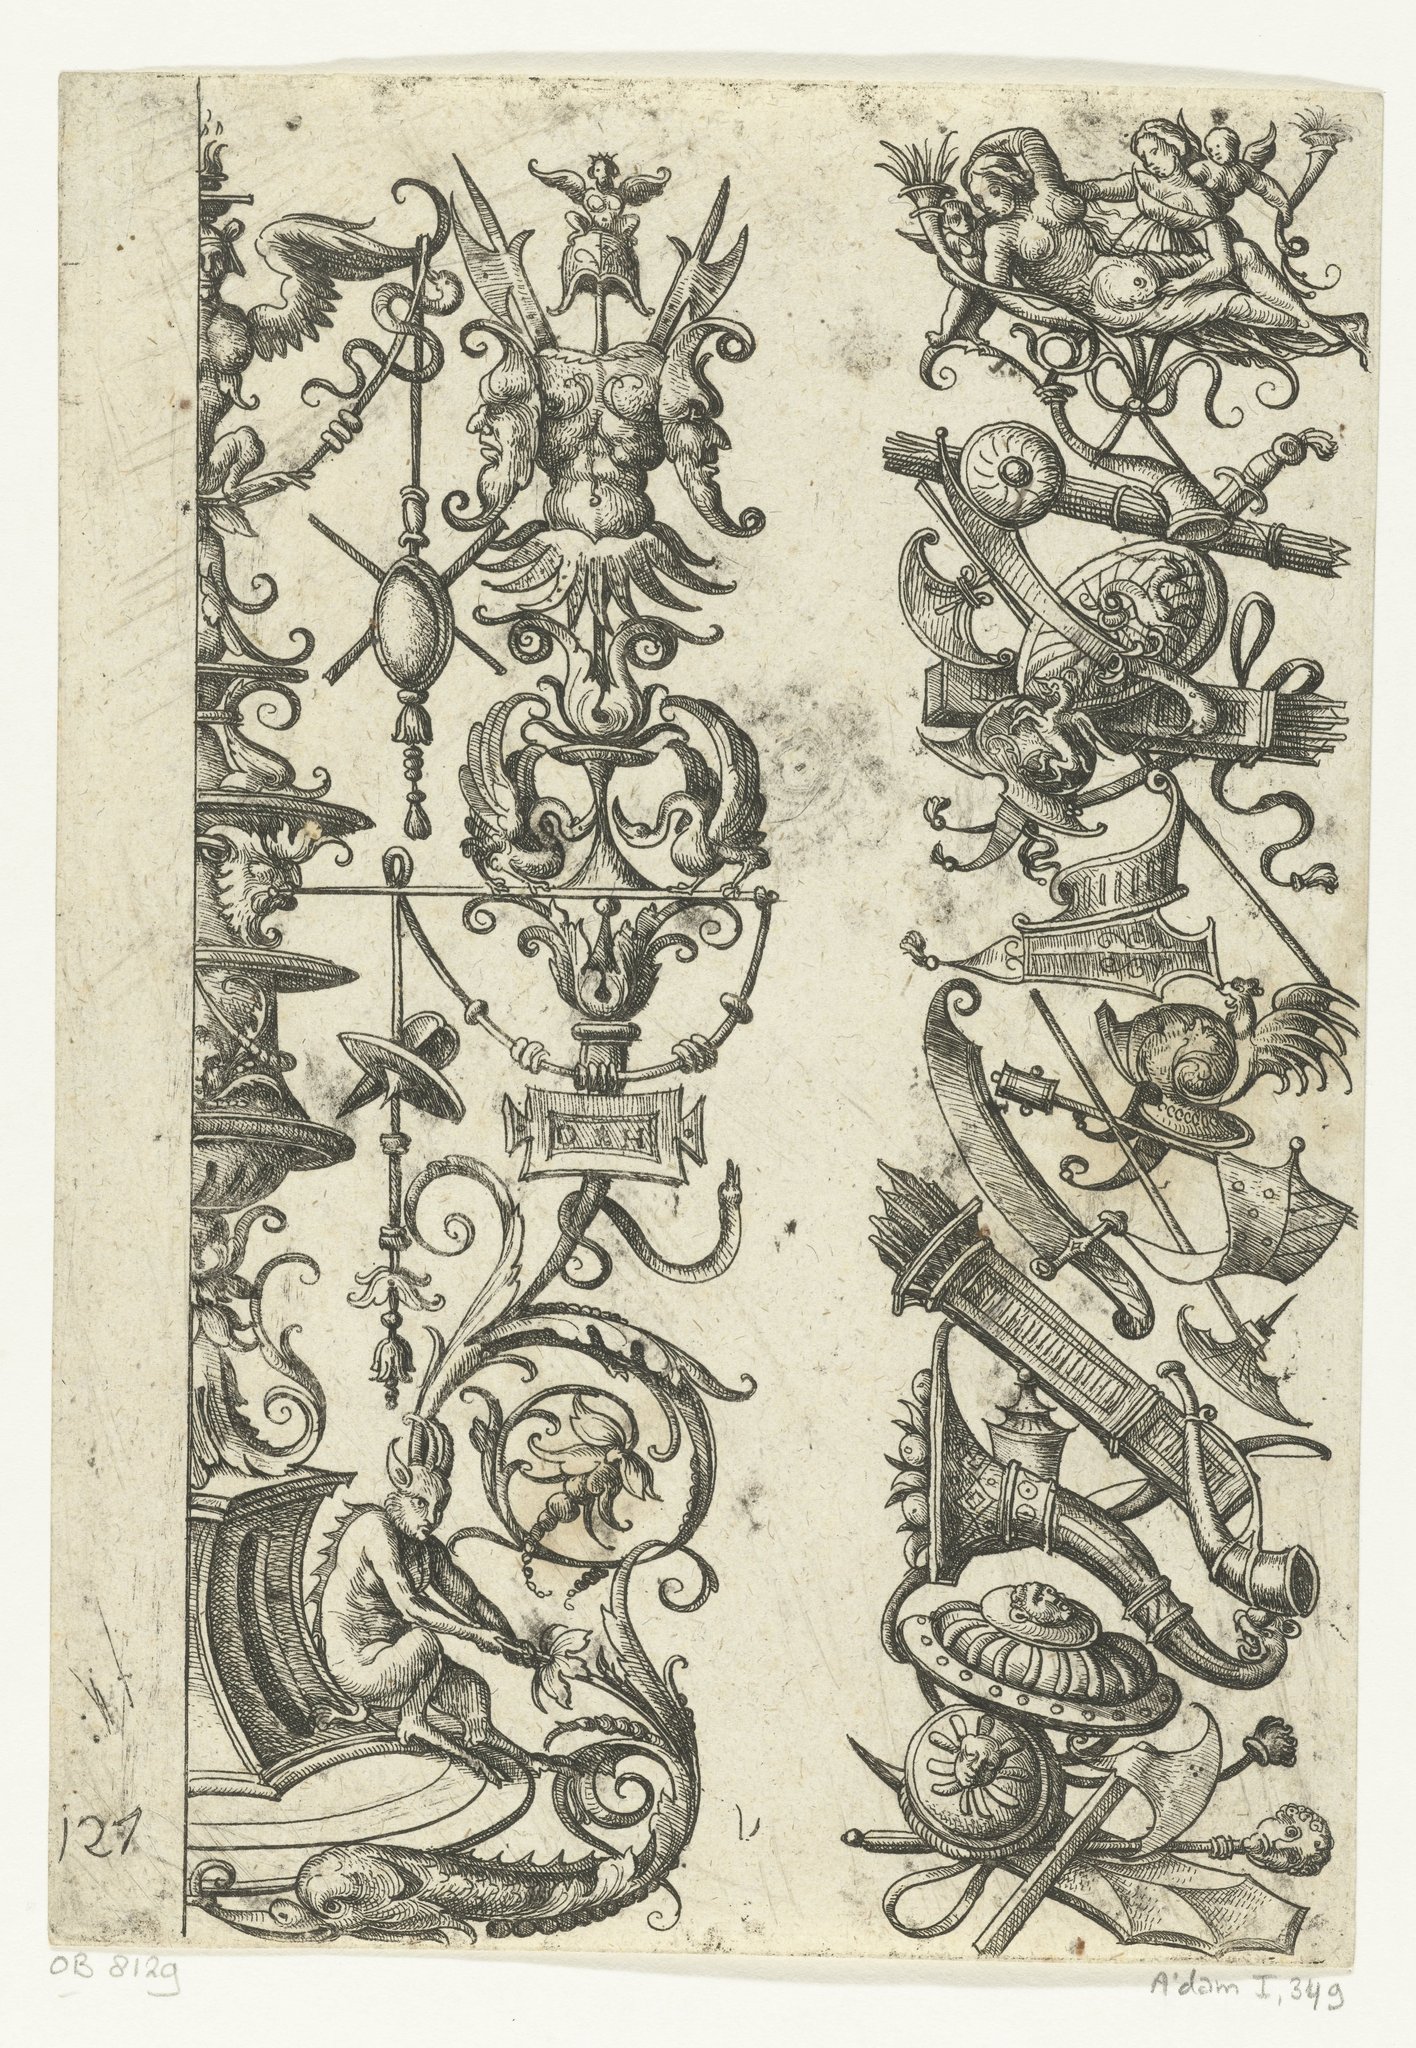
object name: ornament print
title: Vlakdecoraties, links de helft van een kandelaber, rechts een trofee van wapentuig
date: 1480-1536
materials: paper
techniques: etching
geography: germany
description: Links is de helft van een kandelaber zichtbaar met een decoratie van bladranken en grotesken ter rechterzijde. Op de voet zit een sater. Rechts een trofee van wapentuig. Bovenaan wordt Callisto door Jupiter verleid.